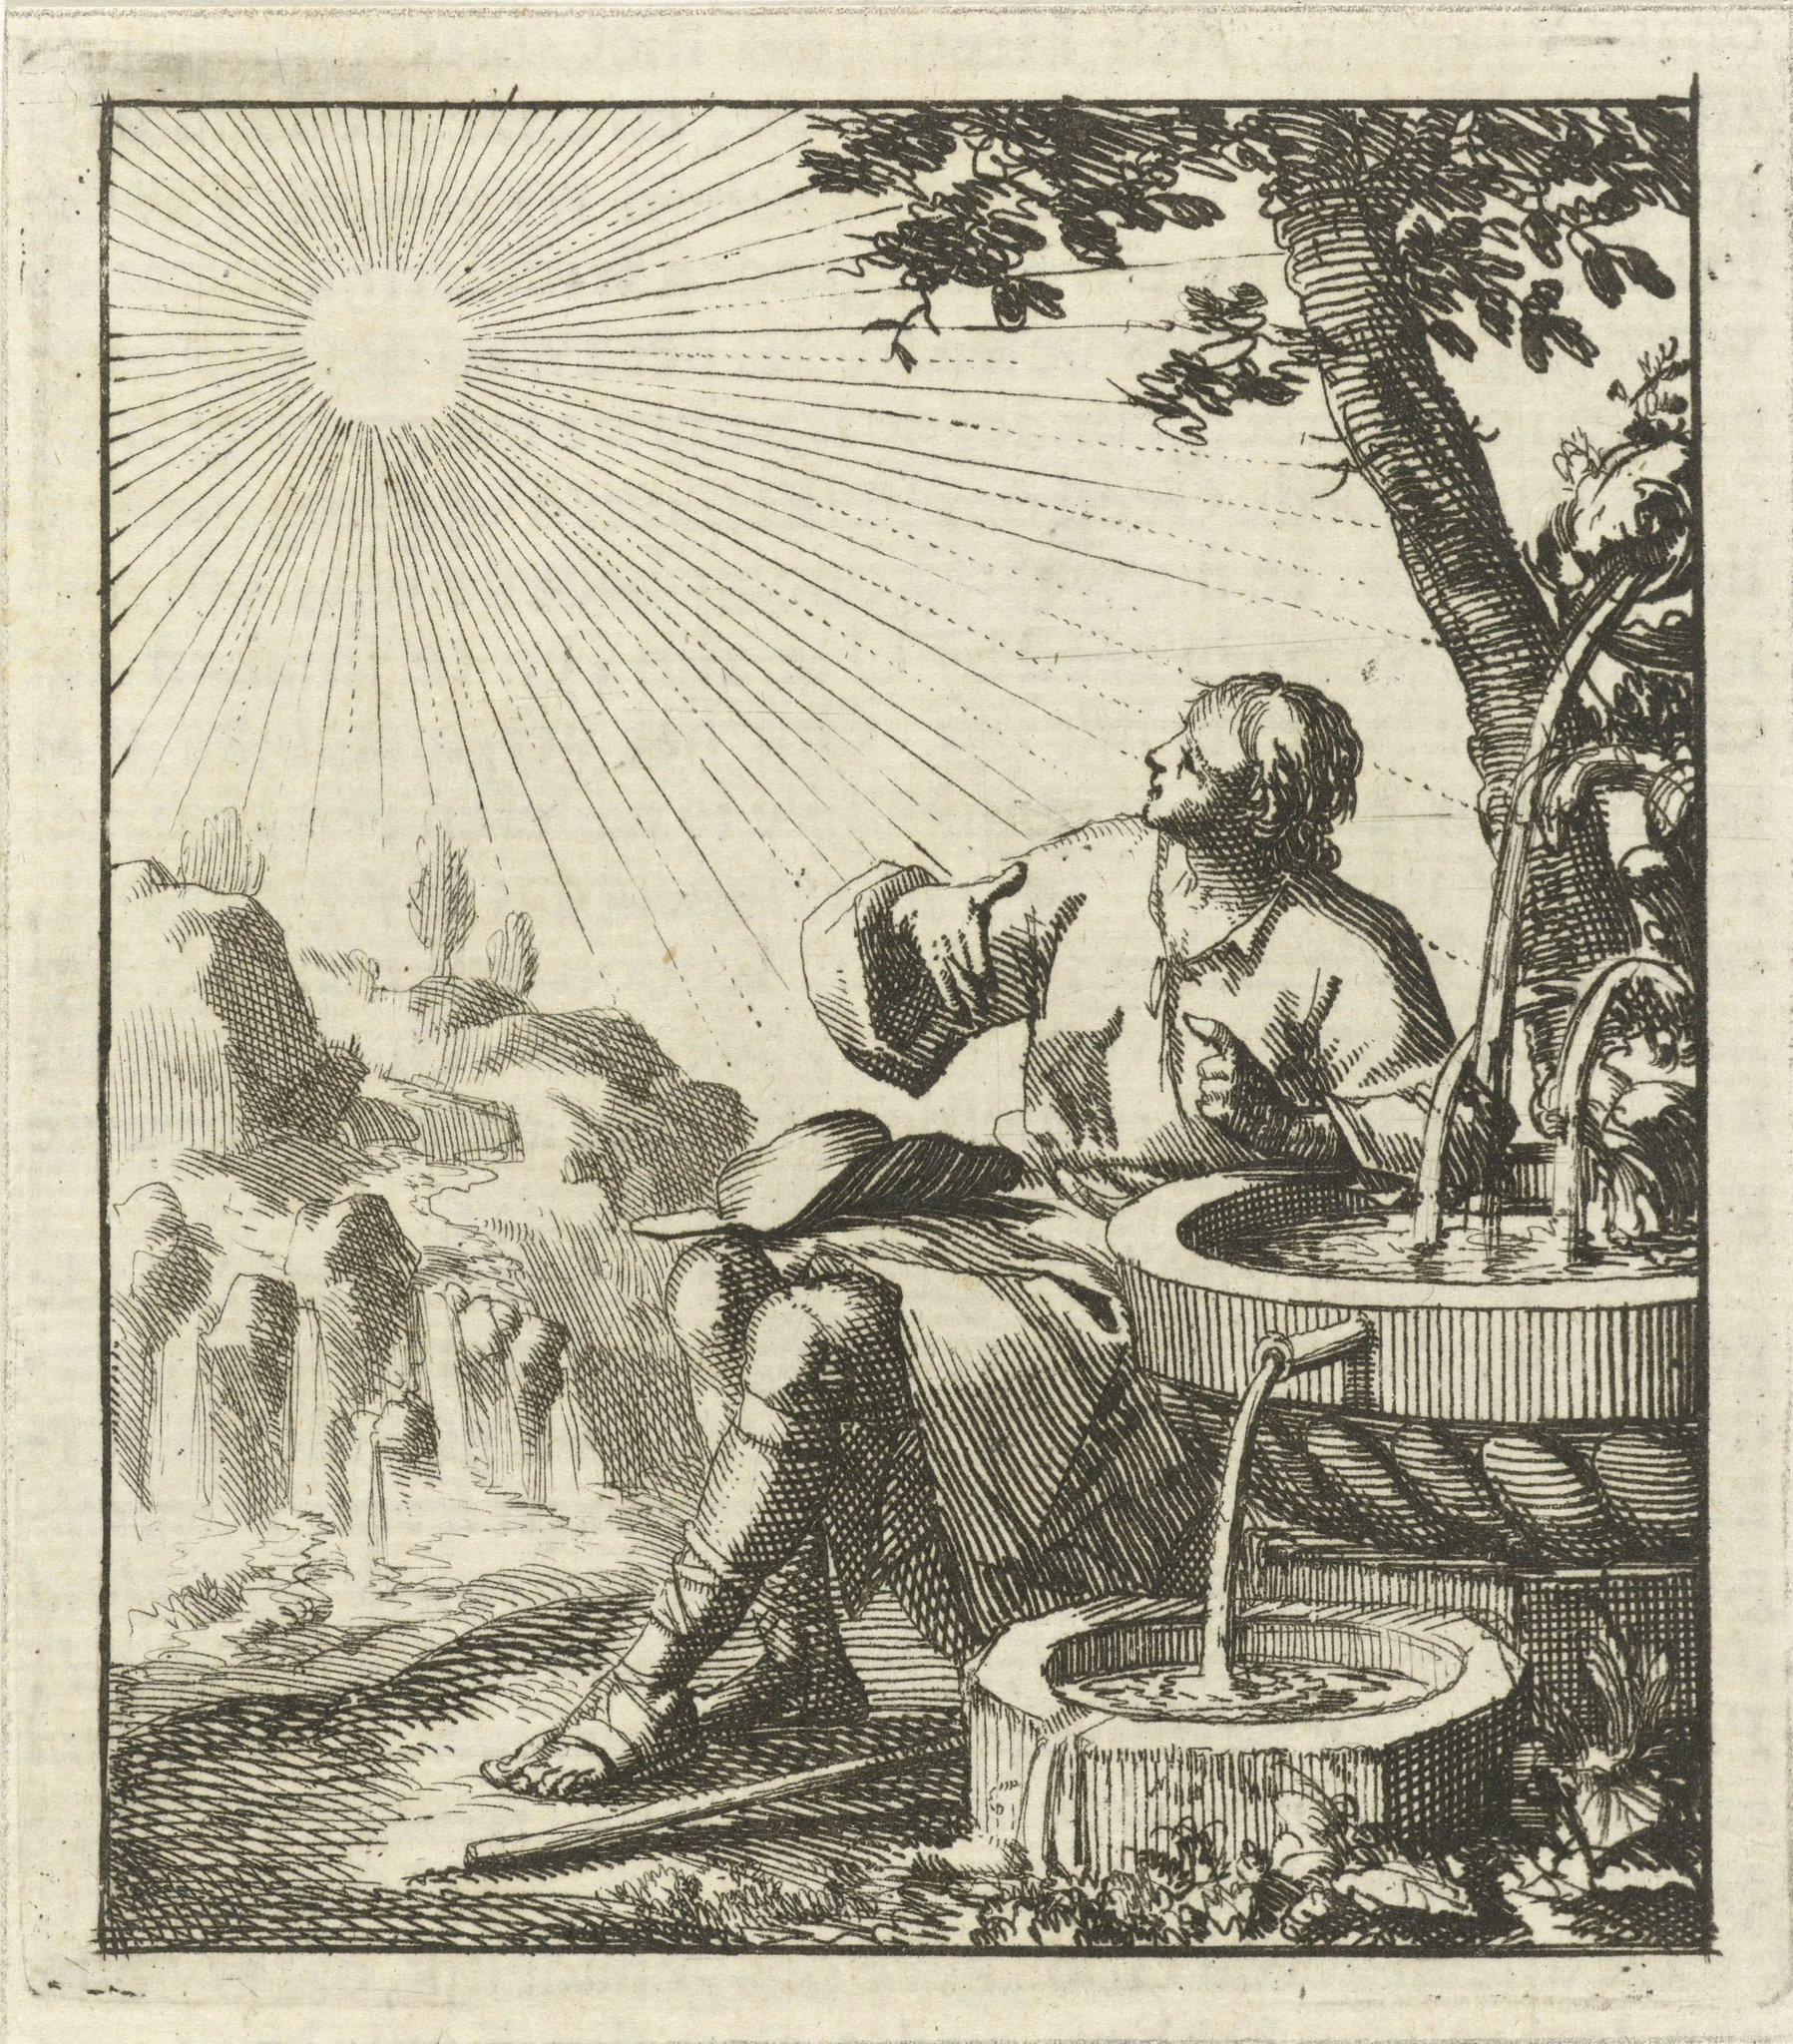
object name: book illustration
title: Gods Liefde-zonne schijnt en gaat, In all' wat voor haar open staat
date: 1689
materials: paper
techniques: etching, letterpress printing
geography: amsterdam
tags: garden fountain, sunlight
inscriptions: collector's mark: Lugt 2228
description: Illustratie uit: Huygen, Pieter. De beginselen van Gods koninkryk in den mensch uitgedrukt in zinnebeelden. Amsterdam: wed. Arentsz. Pieter (II), 1689, p. 110.